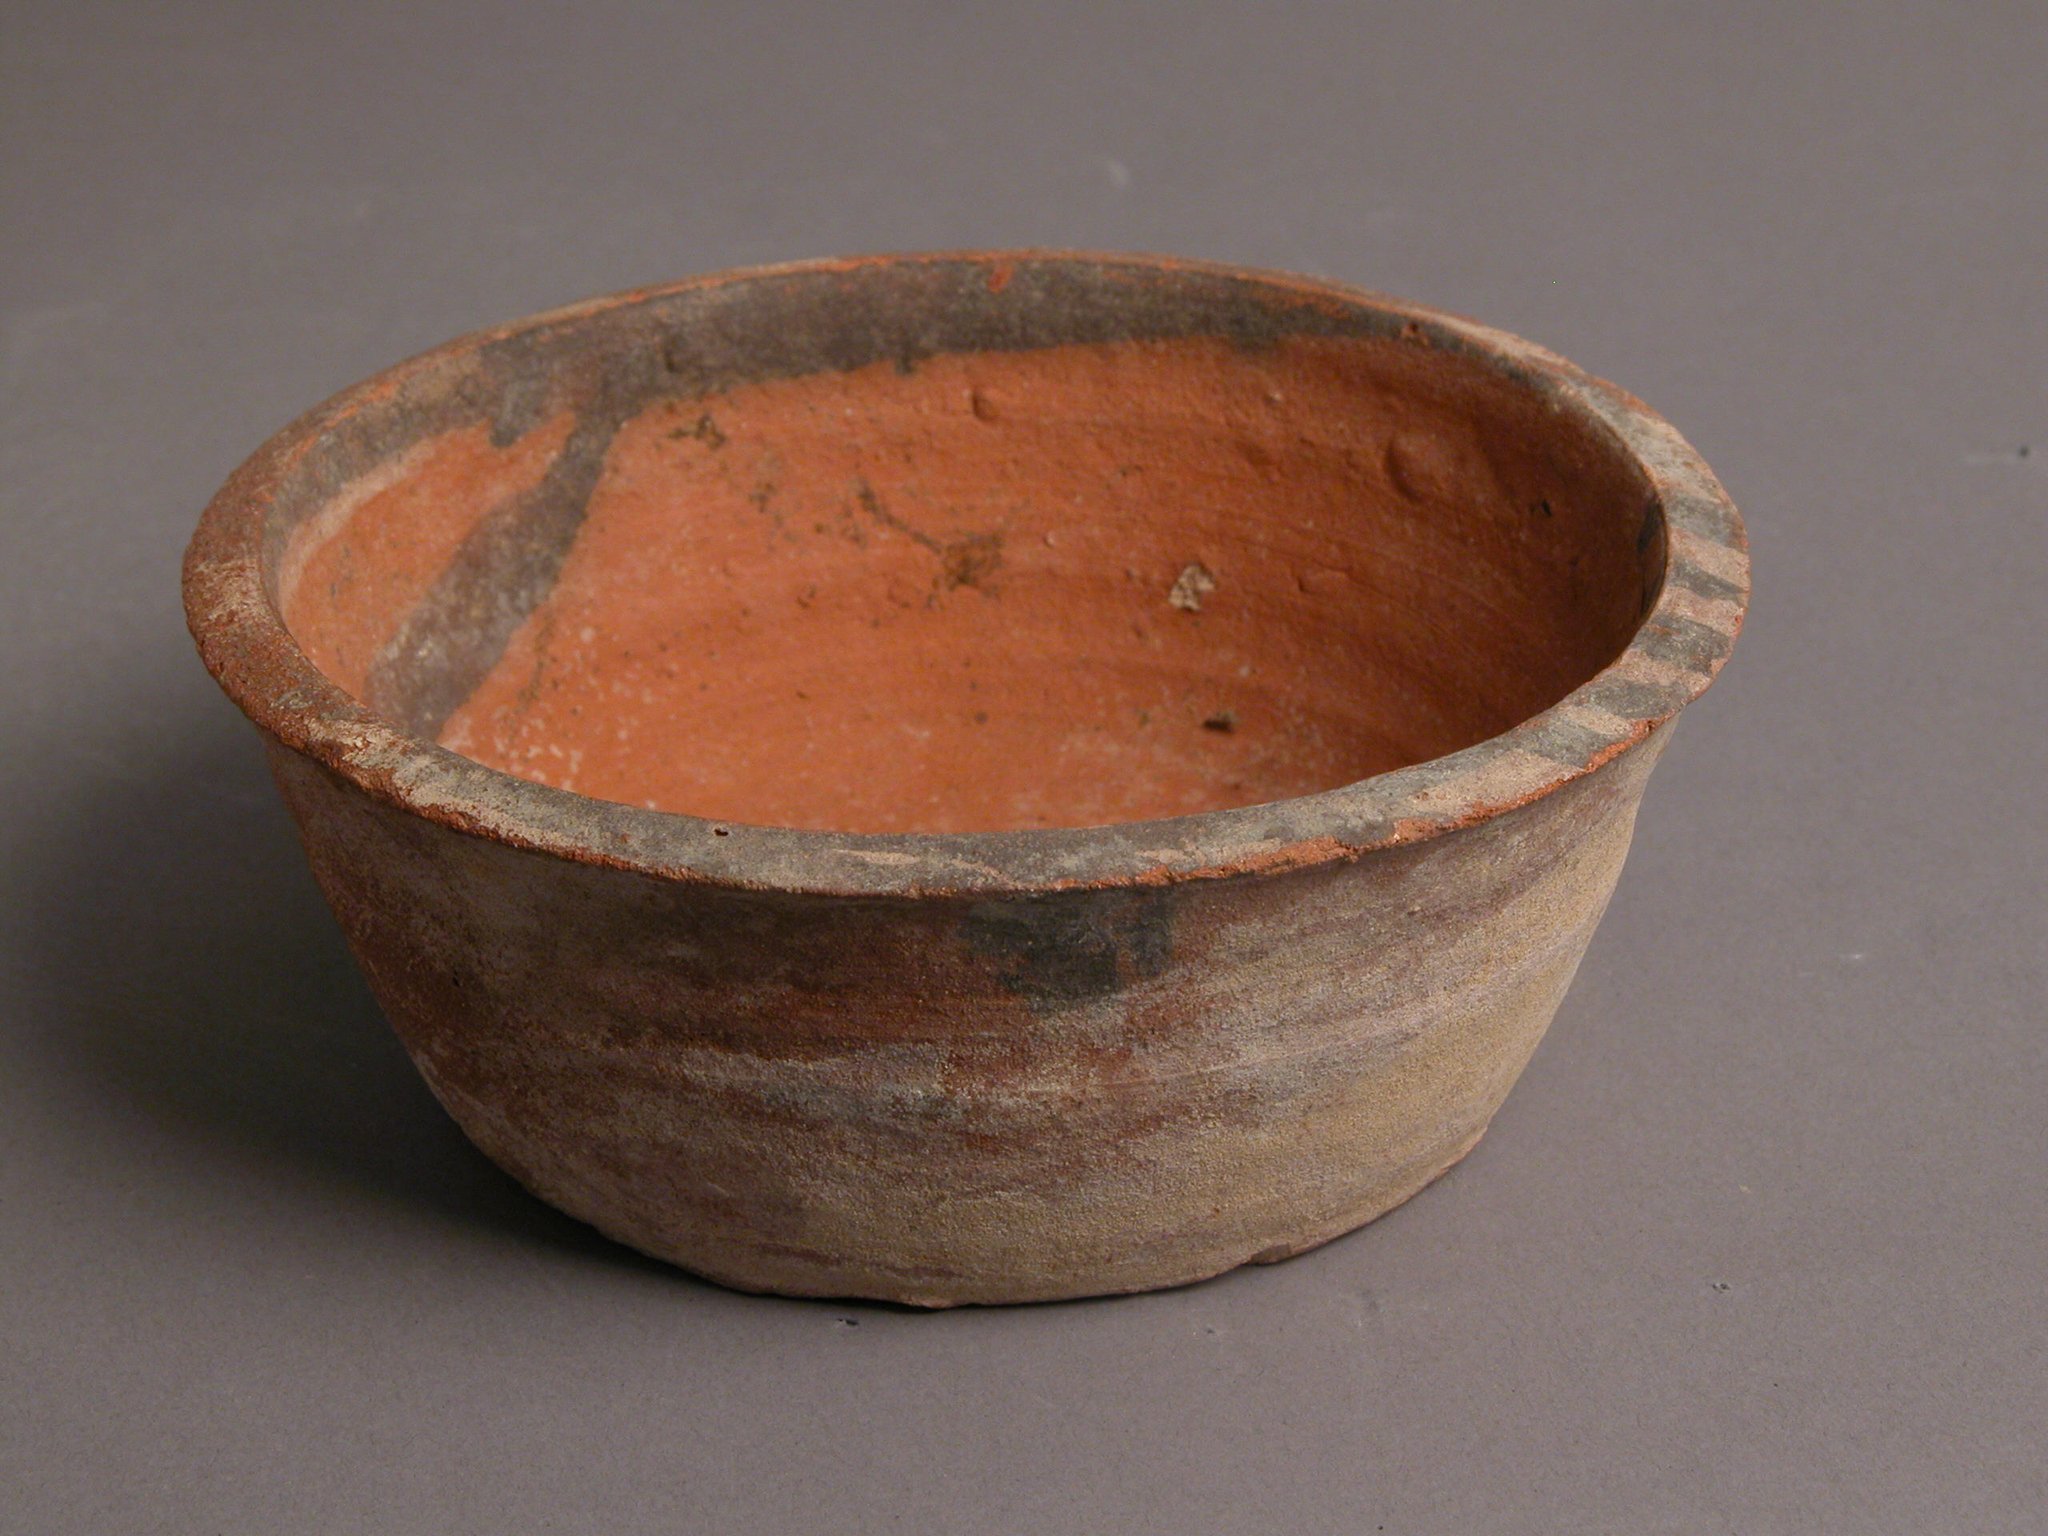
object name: bowl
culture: coptic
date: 301-700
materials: earthenware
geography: egypt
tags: bowls